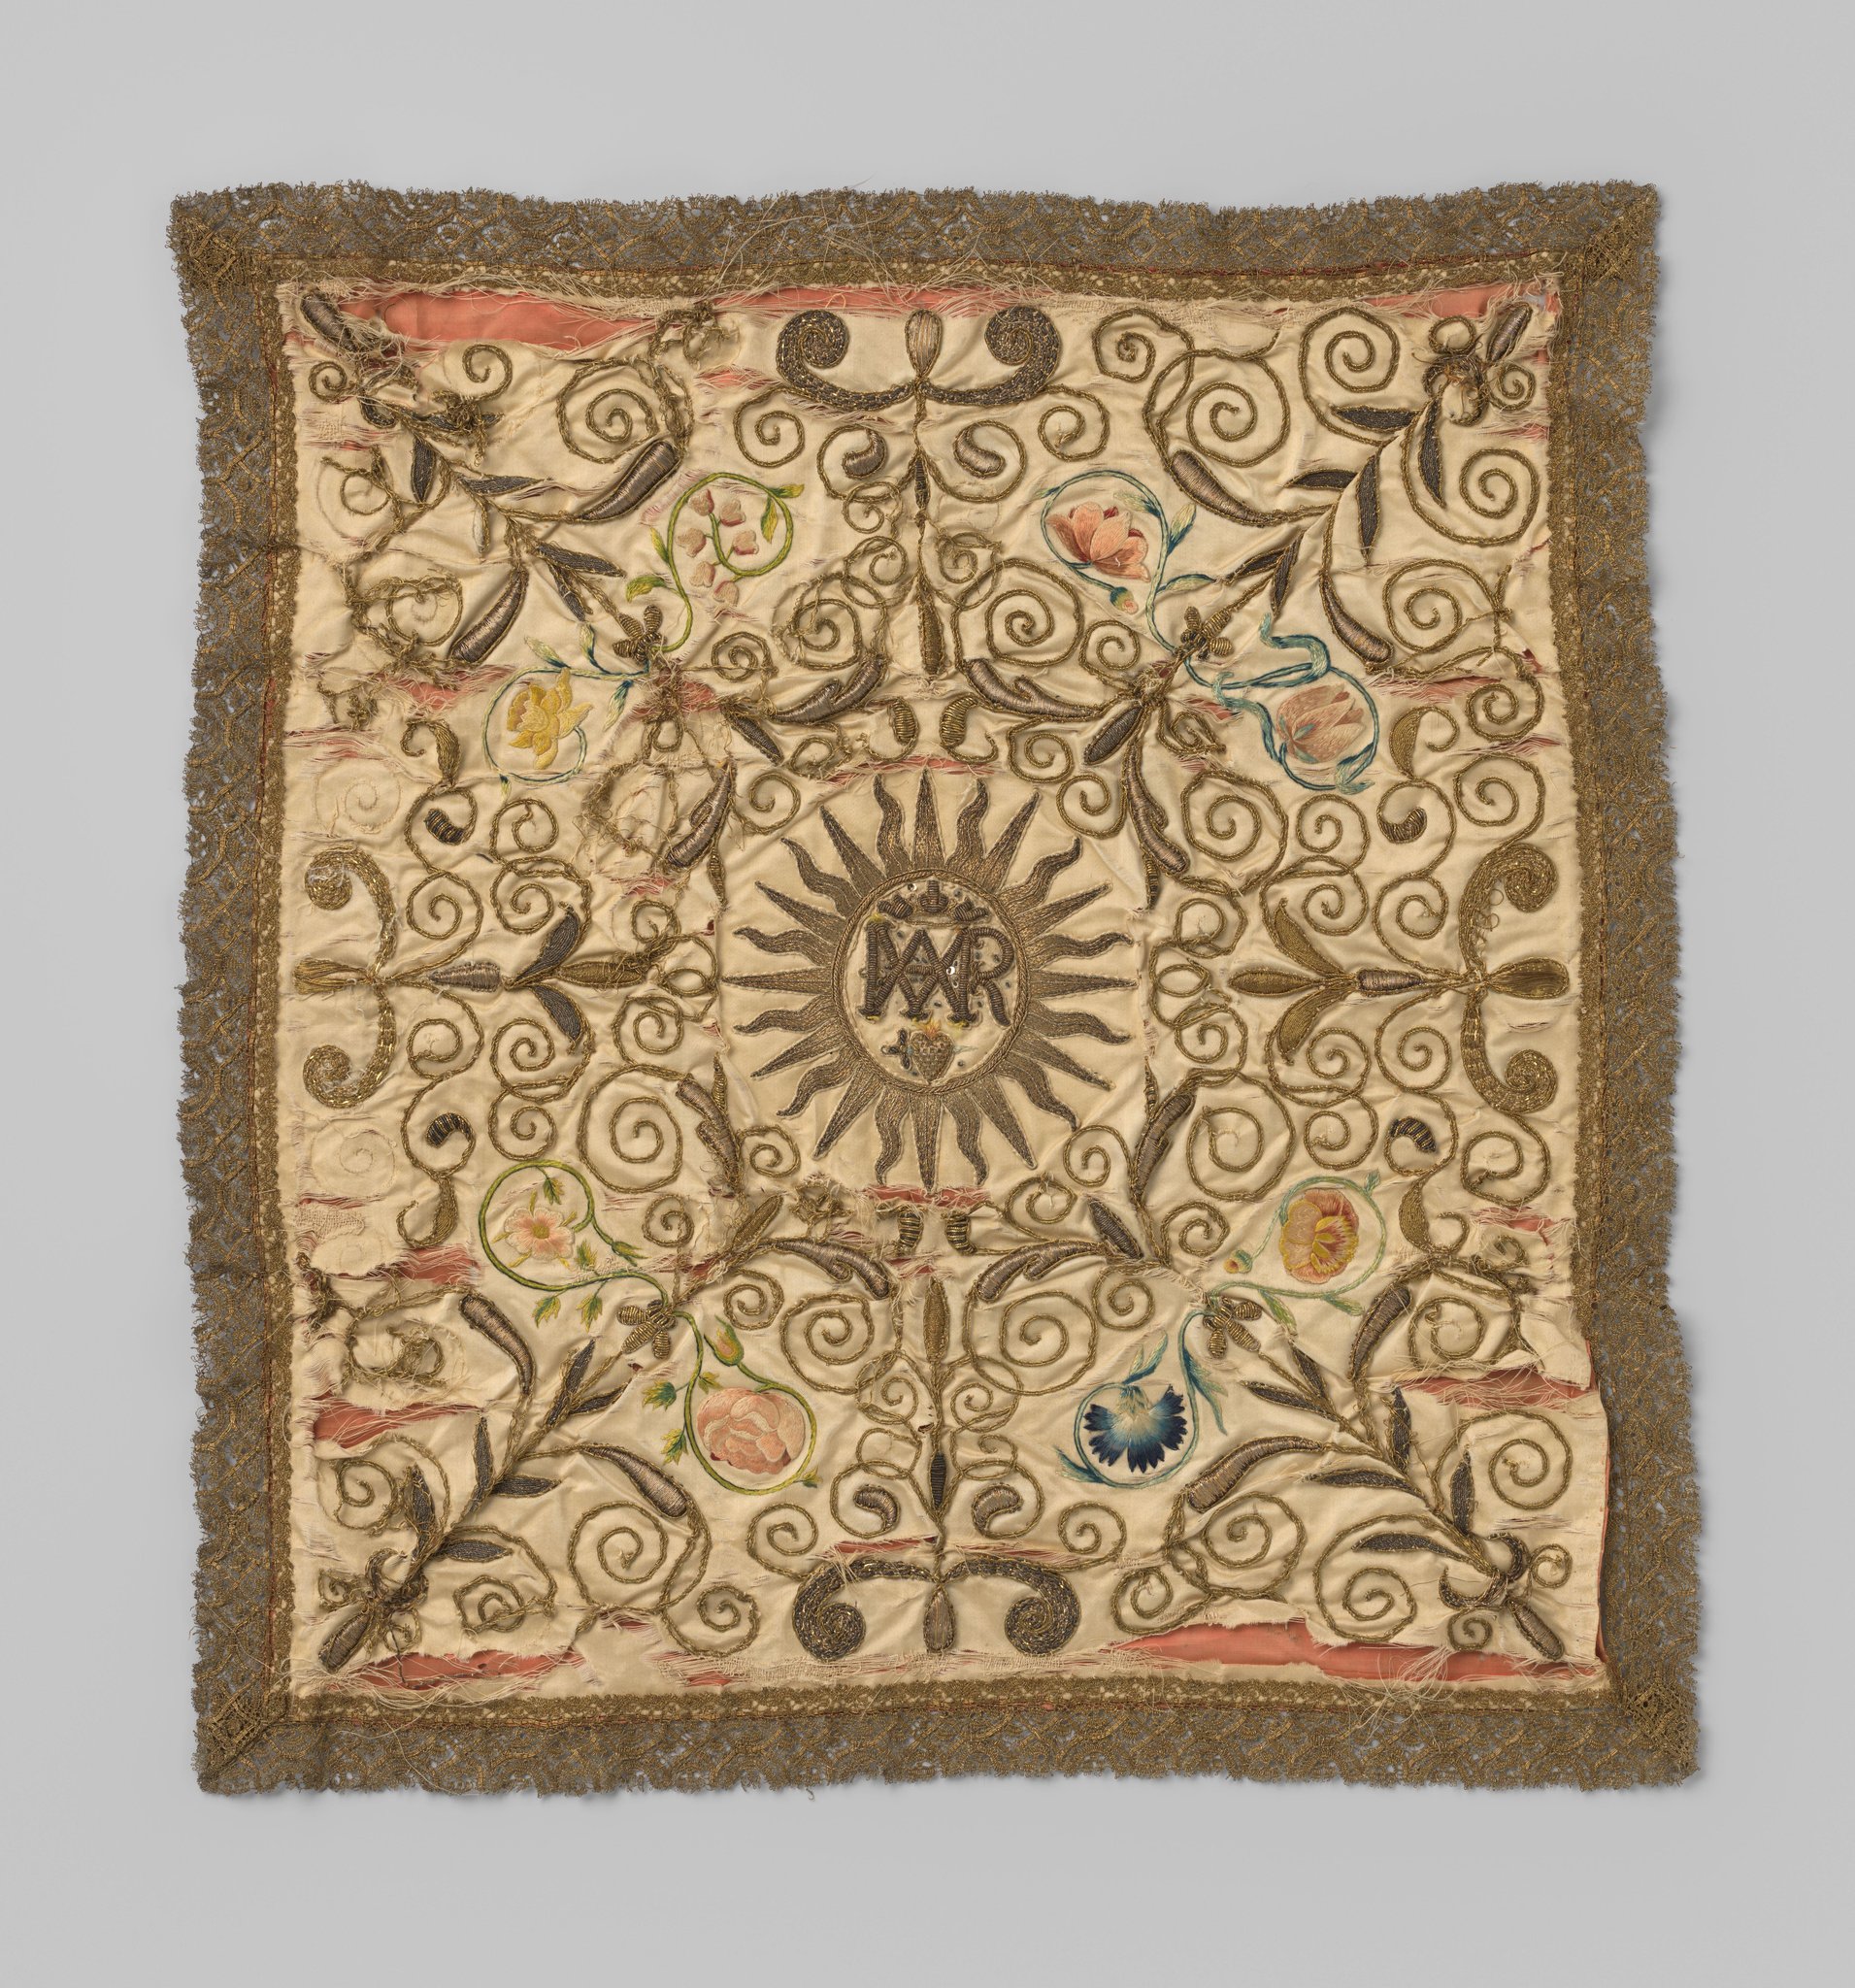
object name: kleed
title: Satijnen kelkkleed met borduurwerk van vlaszijde en goud- en zilverdraad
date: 1600-1699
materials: gold thread, textile, thread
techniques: lace, embroidered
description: Kelkkleed met borduurwerk. In het midden is een stralenkrans waarbinnen de letters MAR geborduurd, waaronder een door een zwaard doorboord hart. Vanuit de hoeken en de middens van de zijkanten lopen voluutranken. Aan de ranken in de hoeken ontspringen bloemen. Het kleed is rondom afgezet met kloskant: goudkant.